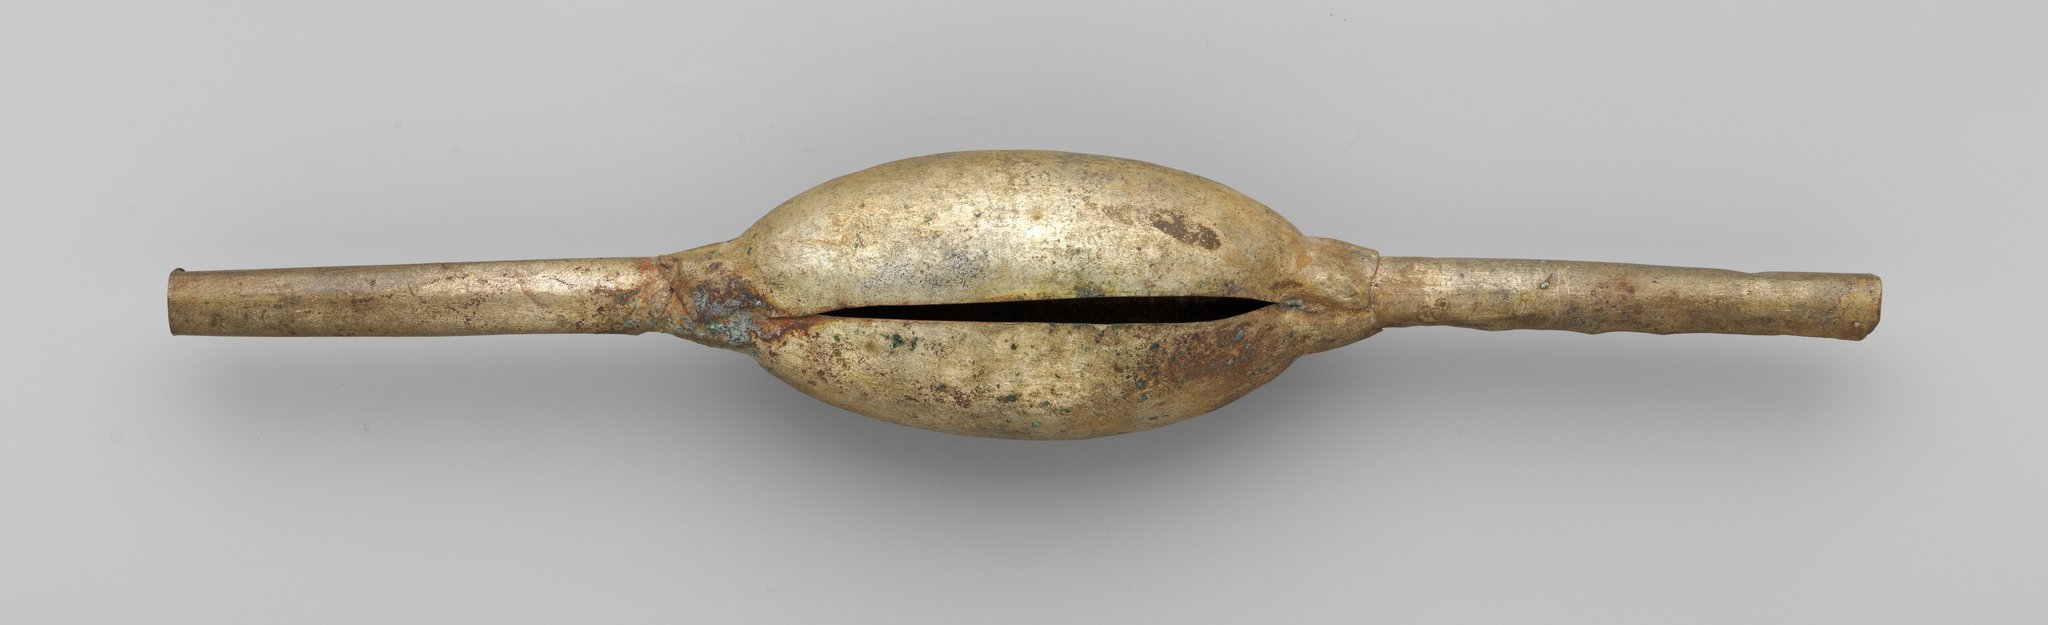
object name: miniature funerary bundle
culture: chancay or chimú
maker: chimú or chancay artist(s)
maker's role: artist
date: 1100-1470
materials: gilt silver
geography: peru